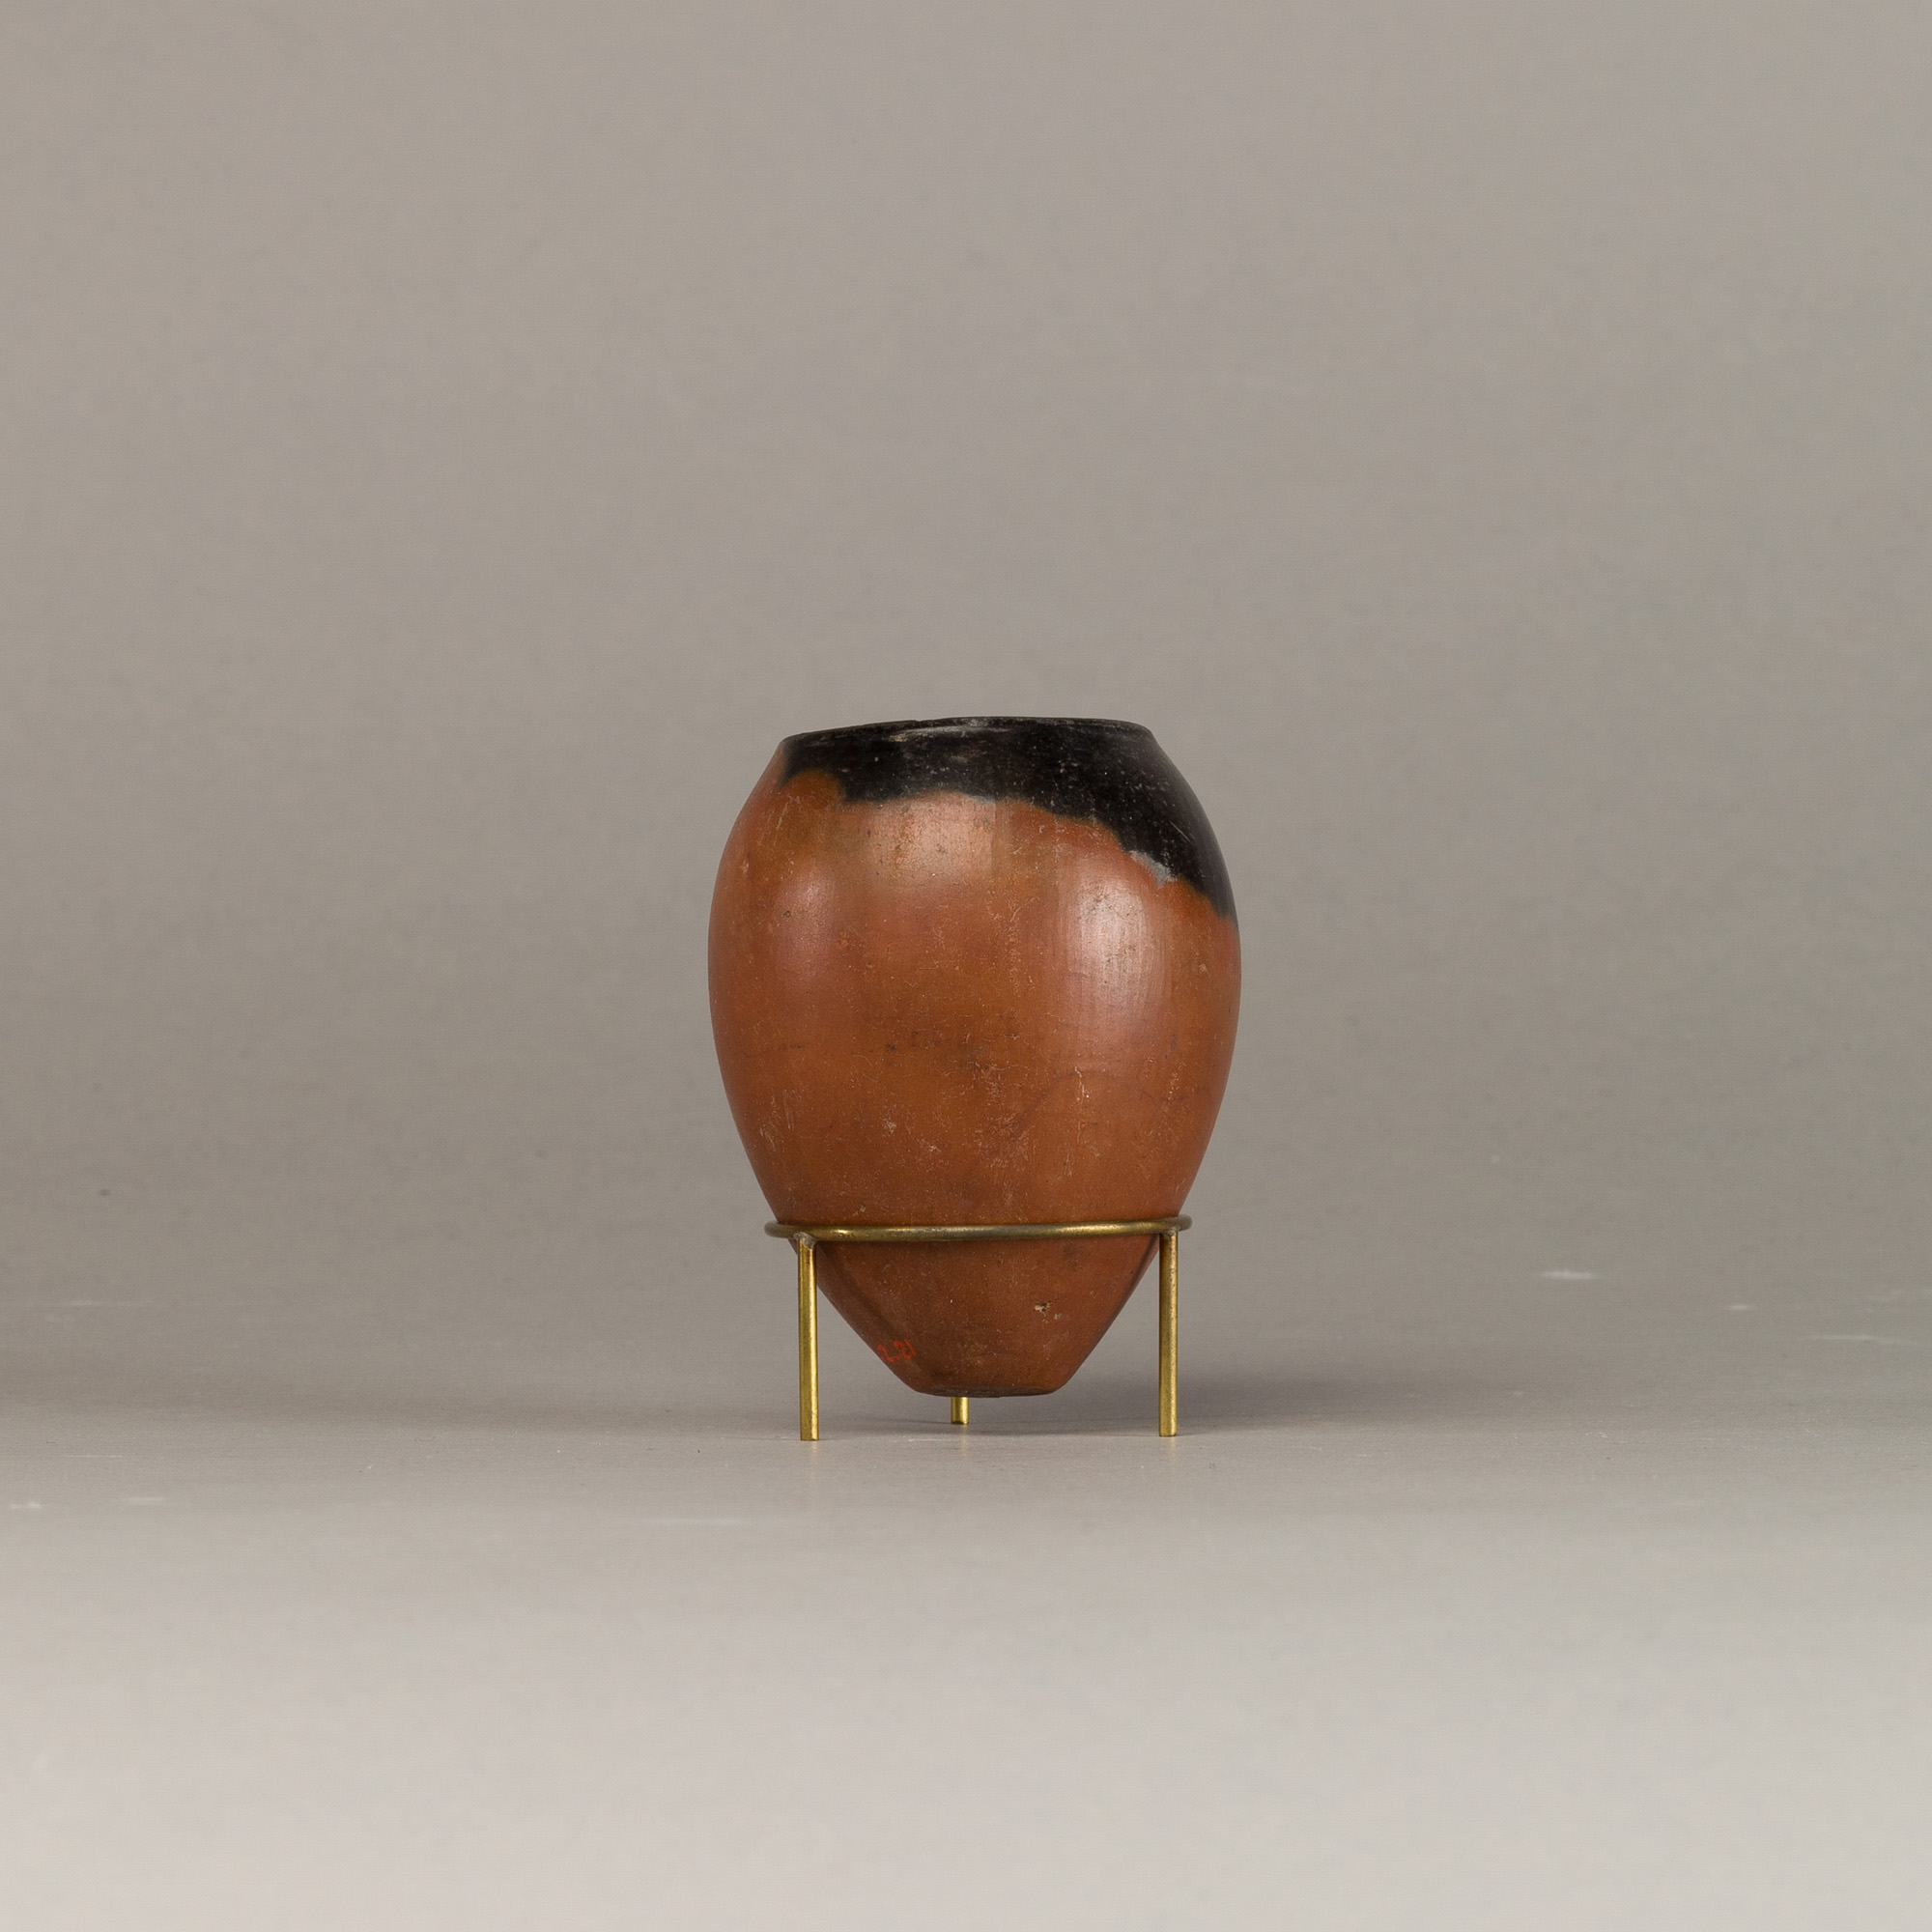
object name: jar, black topped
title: Black-topped Red Ware Jar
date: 3850-2960 BCE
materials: pottery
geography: egypt